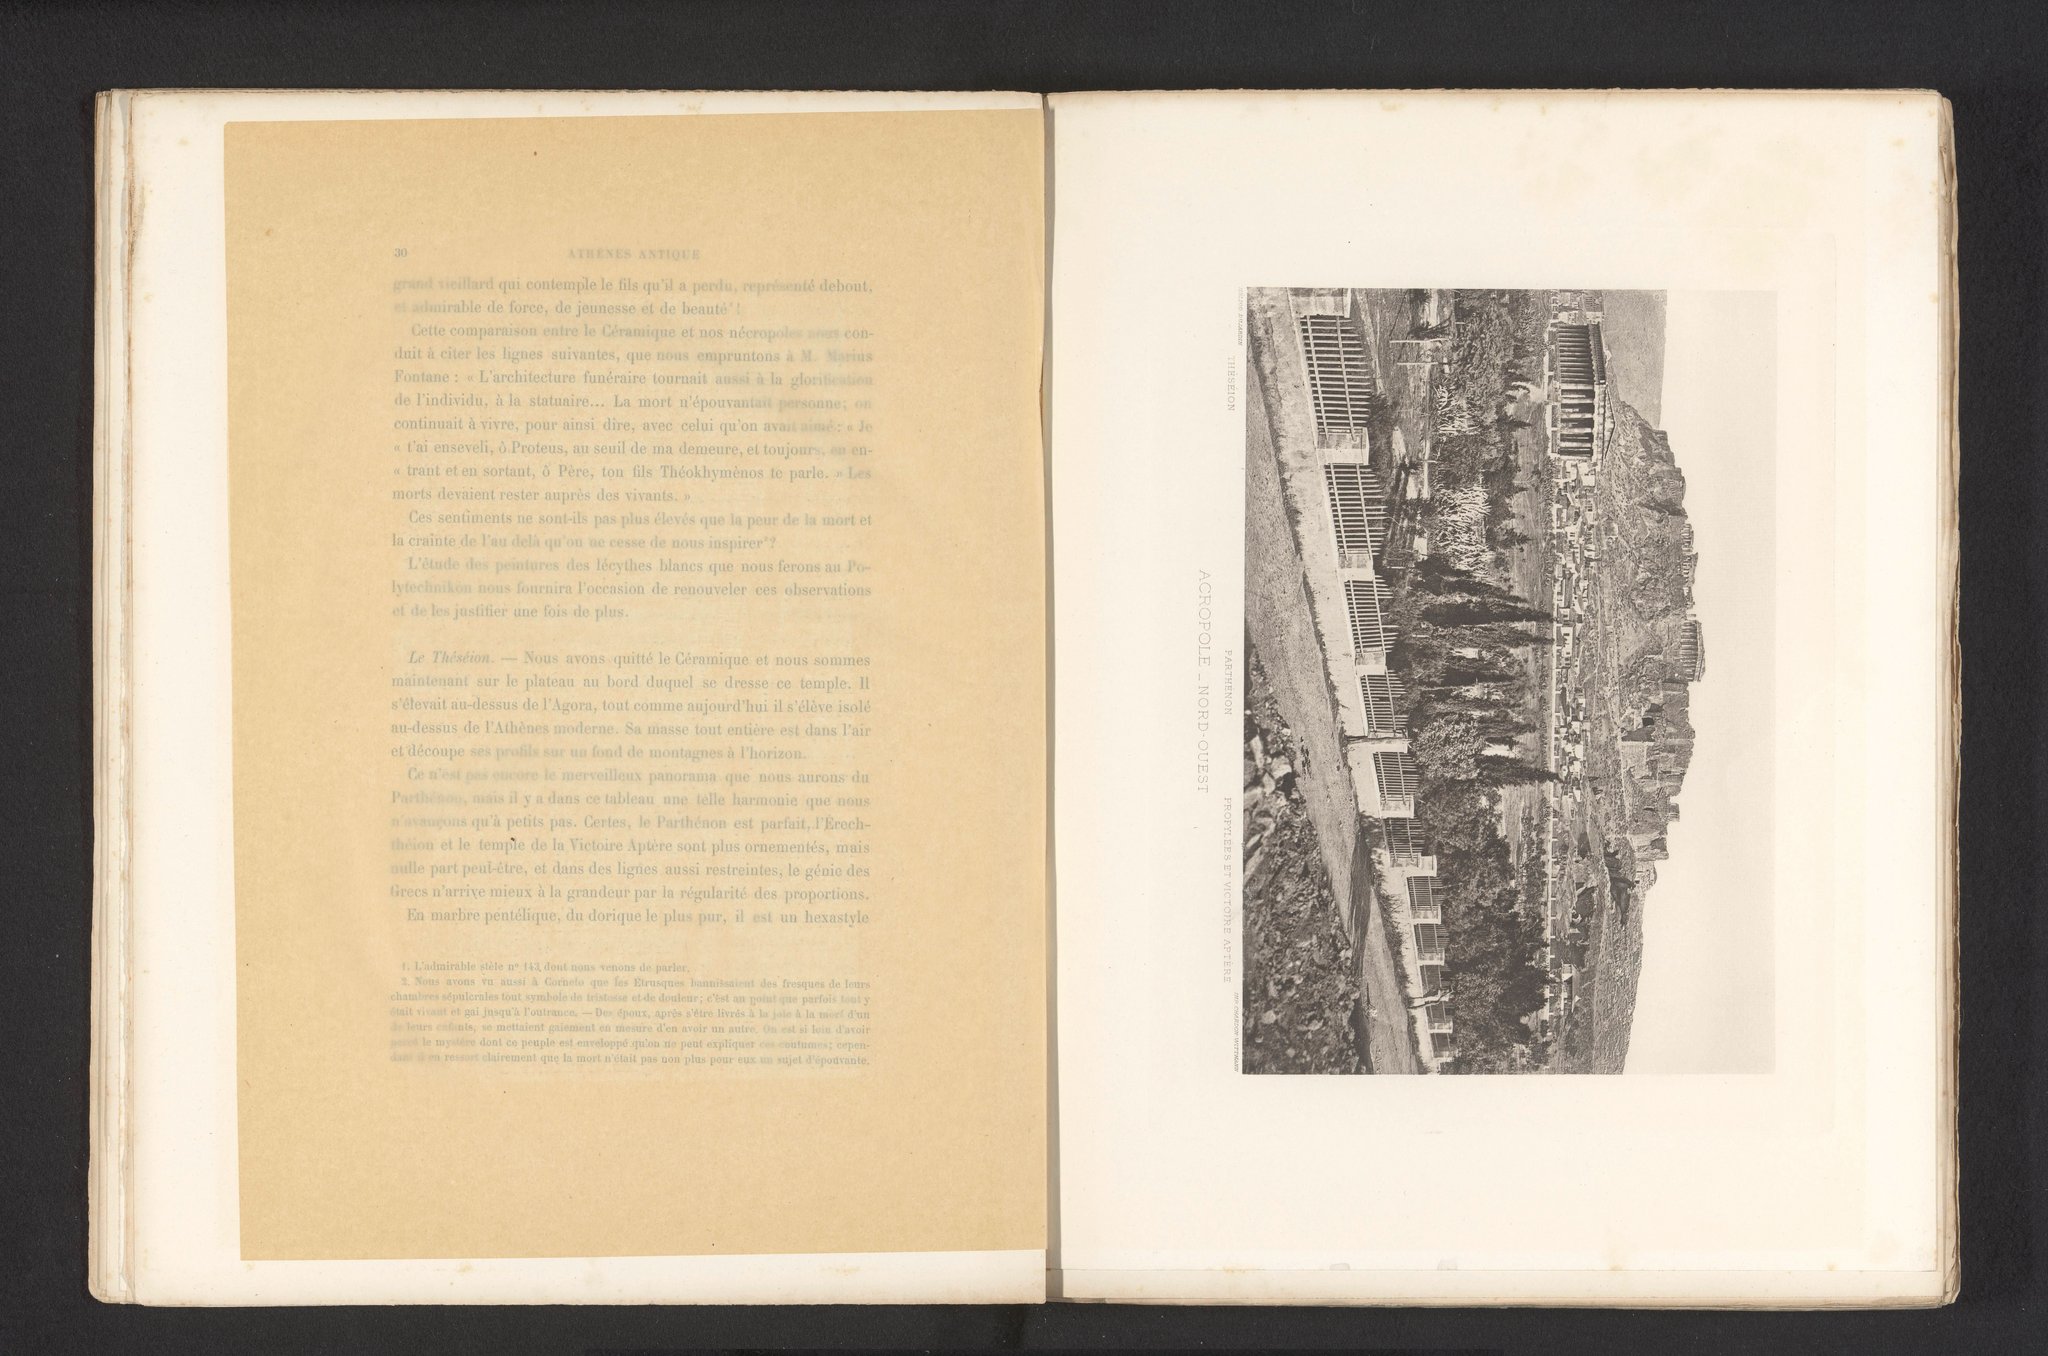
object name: photomechanical print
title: Gezicht op de Akropolis van Athene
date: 1880-1890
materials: paper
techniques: photoaquatint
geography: athens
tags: city-view in general; 'veduta'